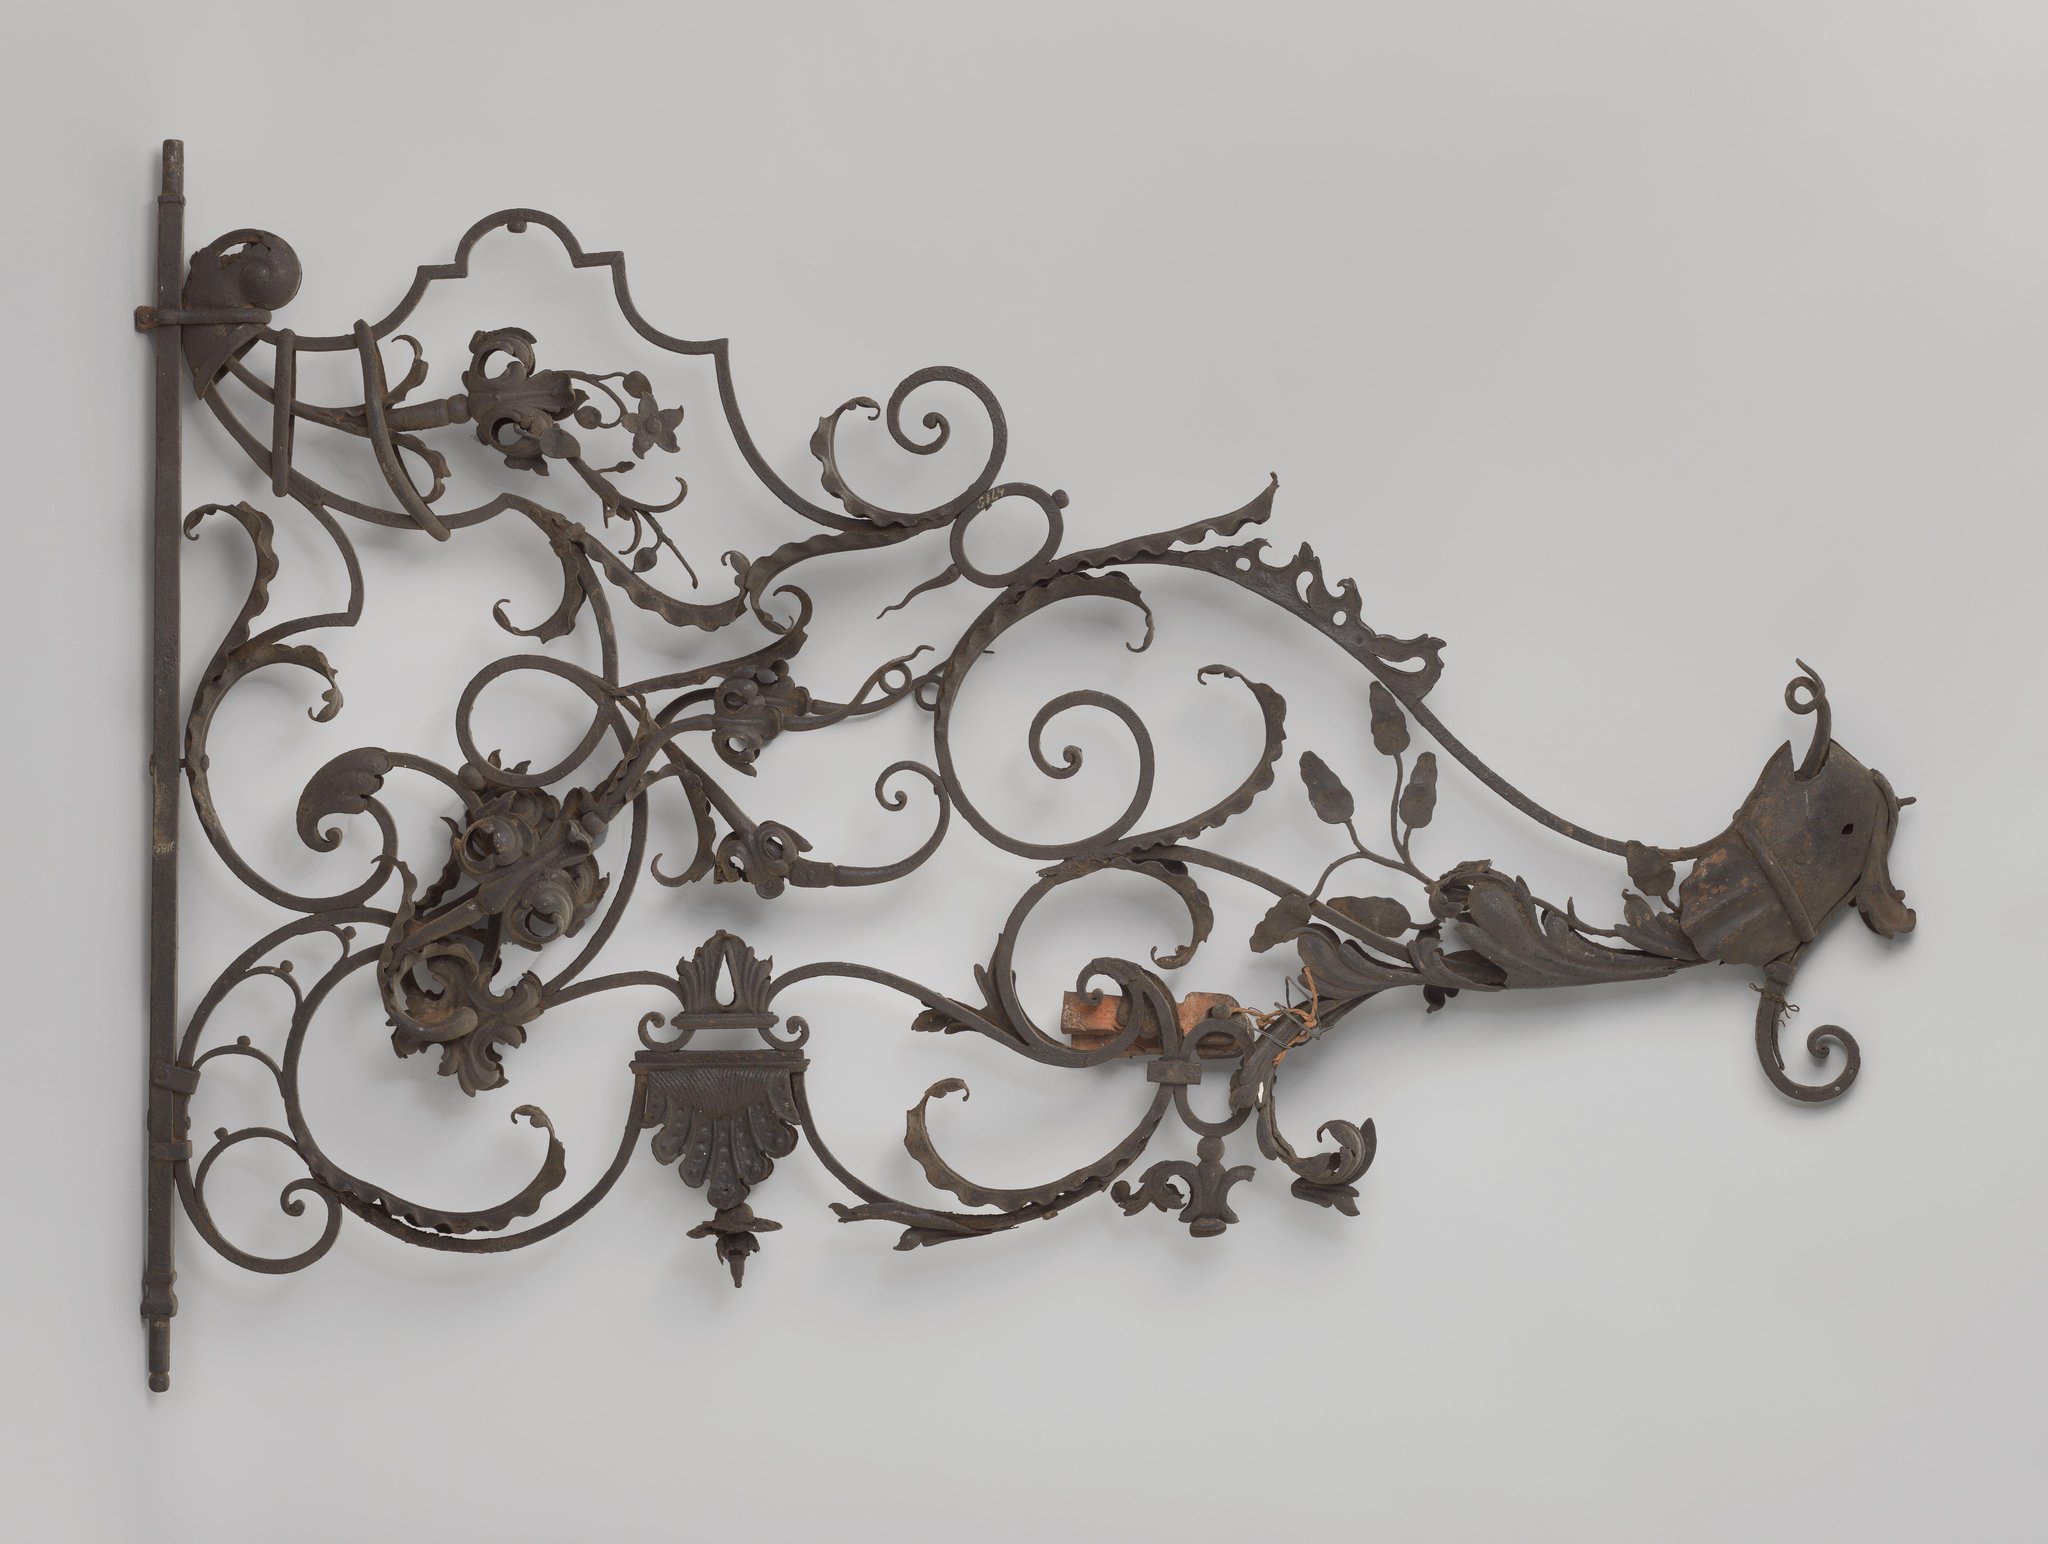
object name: uithangarm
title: Fragment van een arm voor een uithangbord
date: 1675-1700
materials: iron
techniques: repoussé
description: Een grote gedreven ijzeren arm voor een uithangbord. Rijk bloemversieringen, eindigende in een dierenkop. Een los afgebroken fragment.